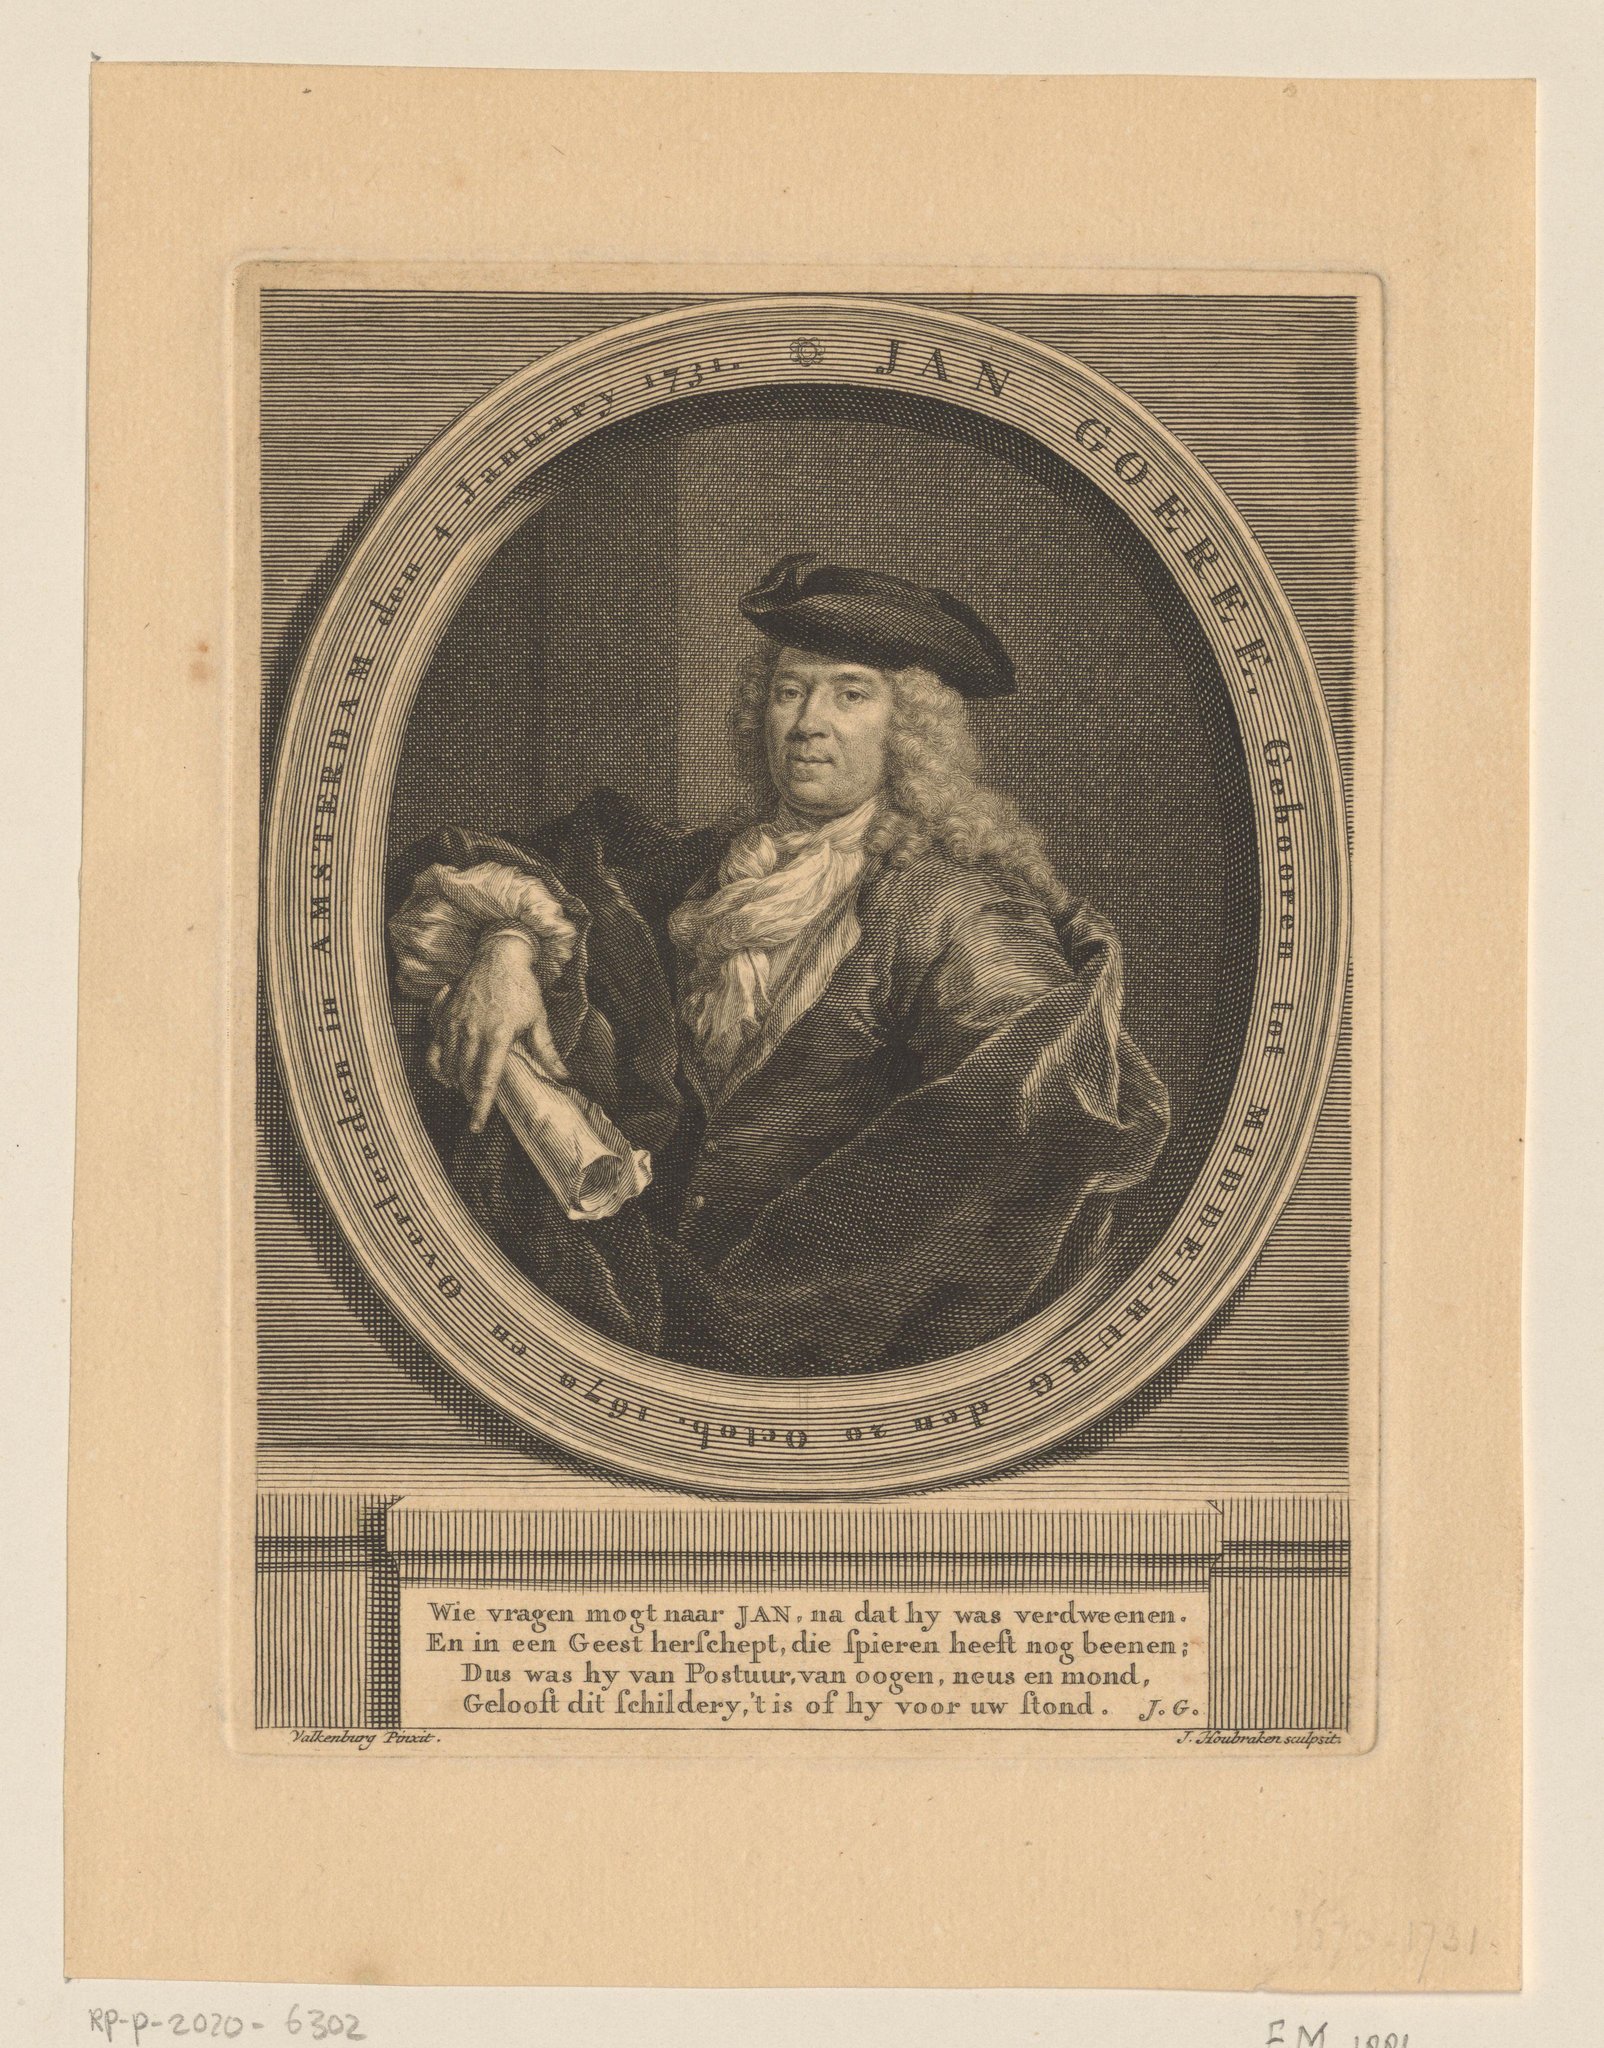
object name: print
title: Portret van Jan Goeree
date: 1731-1780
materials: paper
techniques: engraving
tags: middelburg, amsterdam, print maker, draughtsman, jan goeree, historical persons, portrait, self-portrait of painter